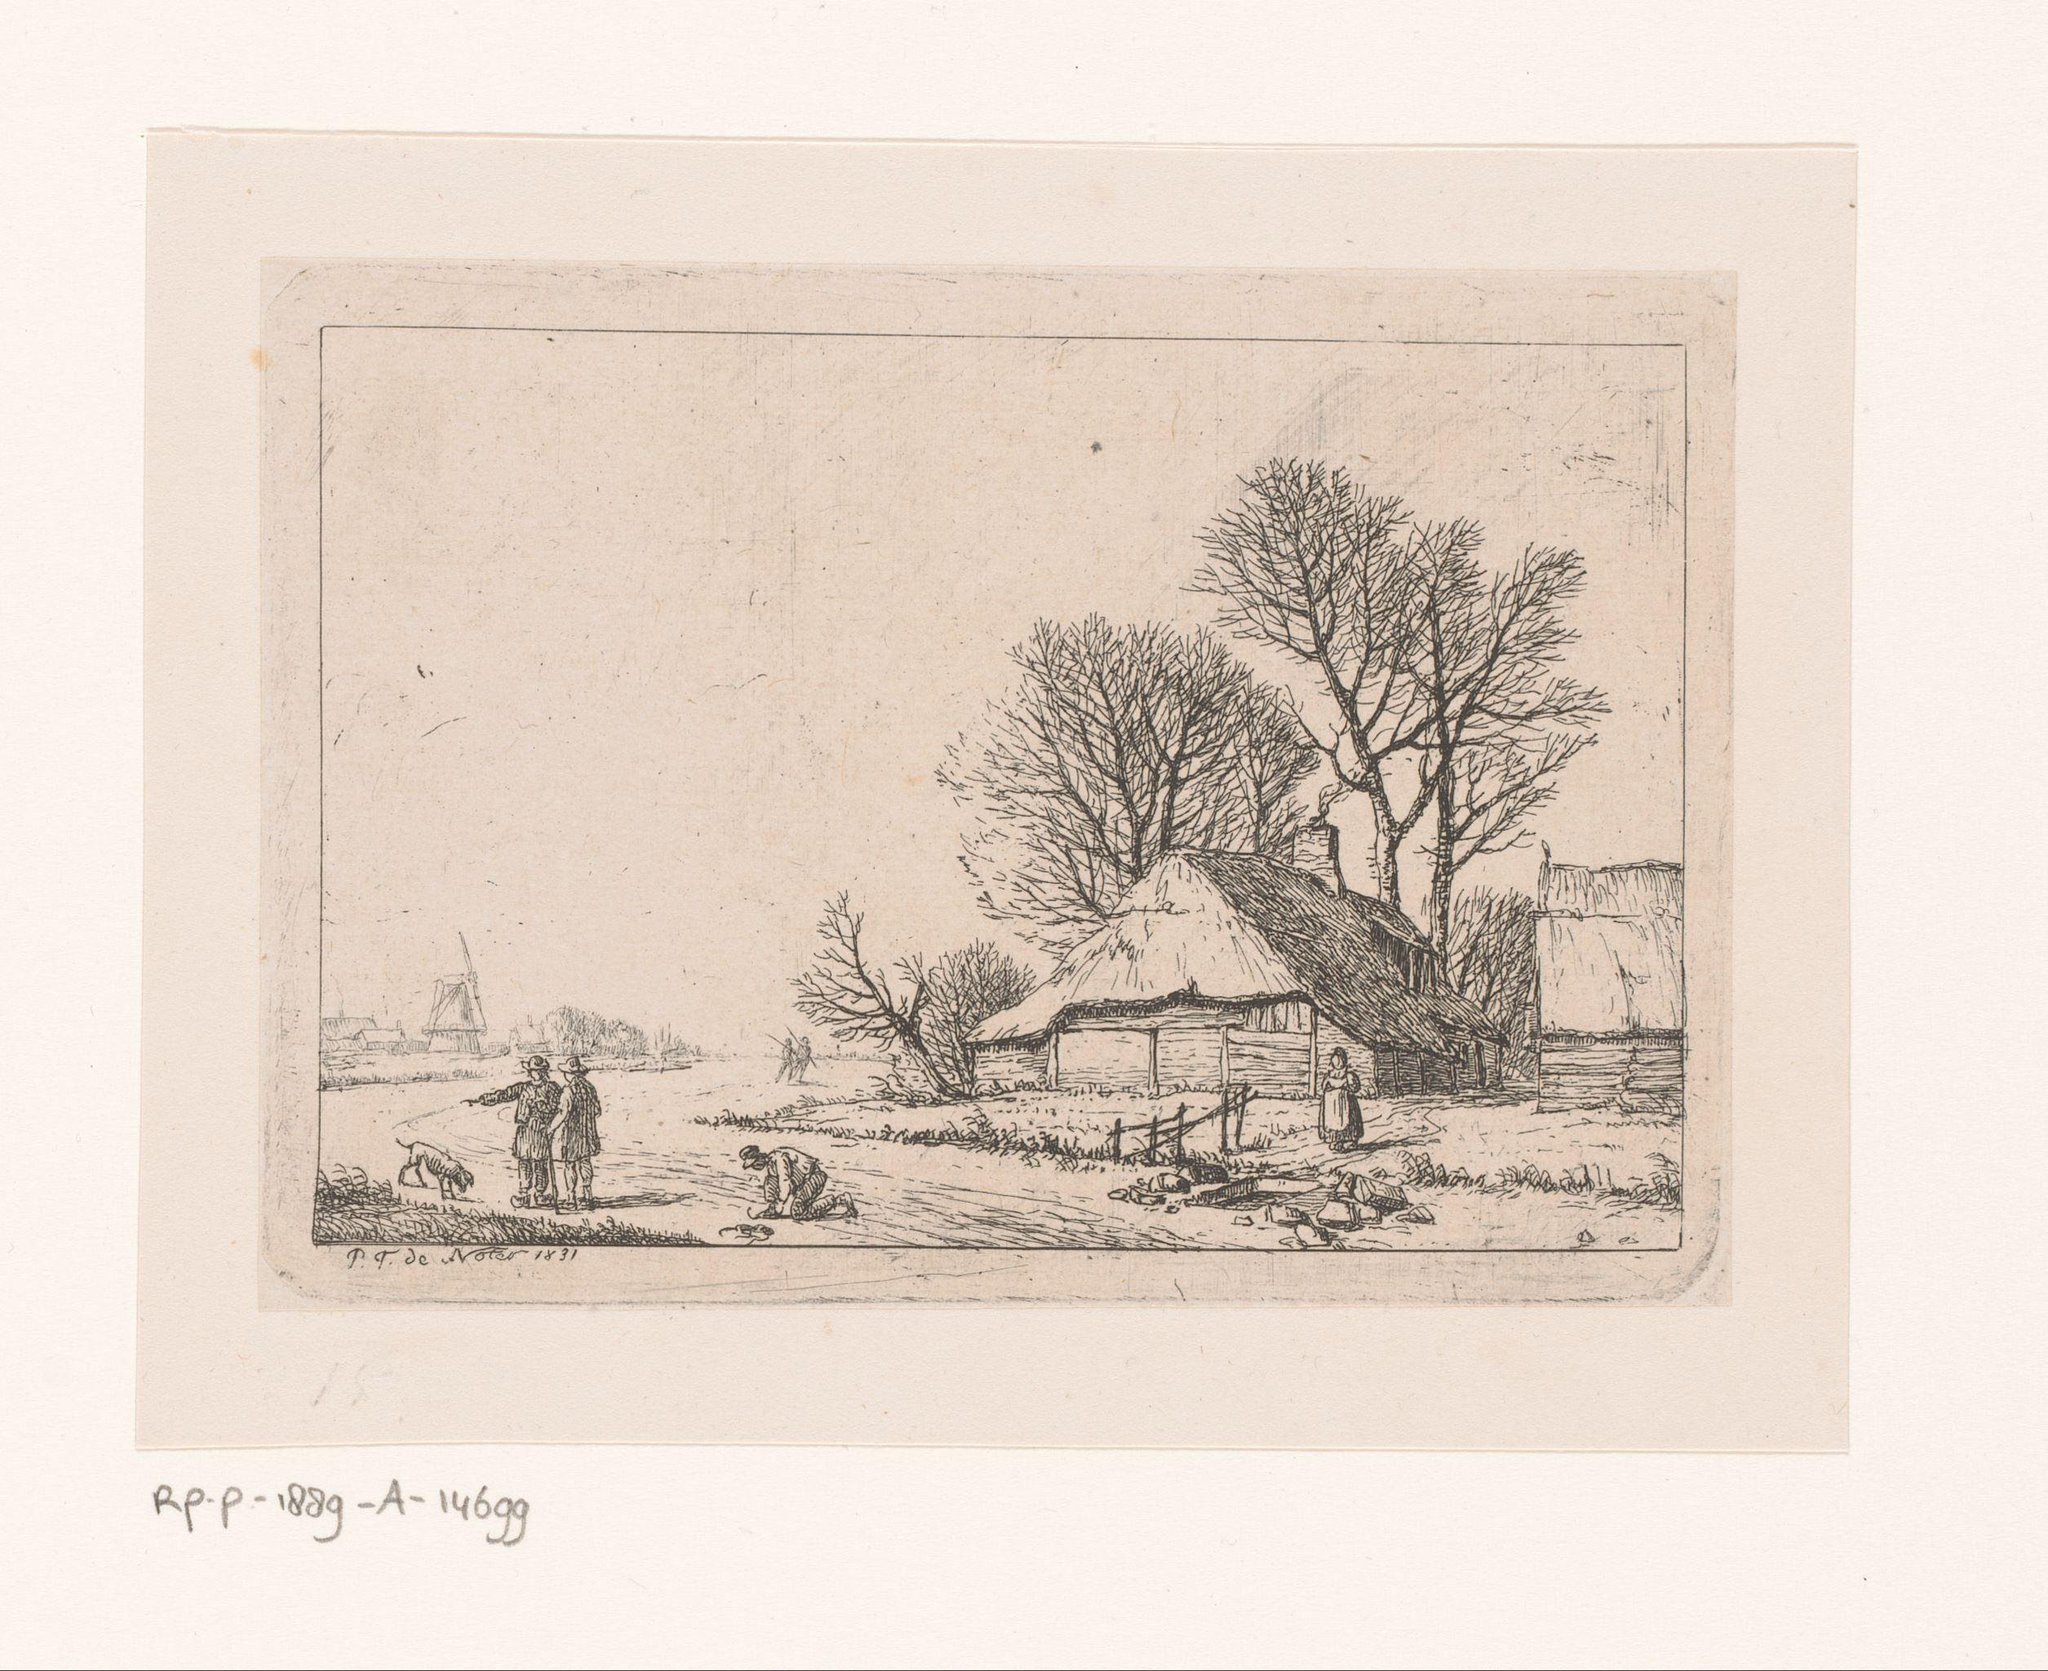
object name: print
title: Winterlandschap met figuren op het ijs en een vrouw op de kant bij een wak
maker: pierre françois de noter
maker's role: painter, print maker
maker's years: 1779-1843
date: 1831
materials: paper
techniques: etching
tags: winter landscape; landscape symbolizing winter (the four seasons of the year), skates (winter sports), ice ~ state of water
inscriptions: collector's mark: Lugt 2228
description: Prent behoort mogelijk tot de prentserie: Recueil de Gravures à l'eau forte, dont plusieurs d'apres Hobbema, par P.F. de Noter. Gent: s.n., 1831.